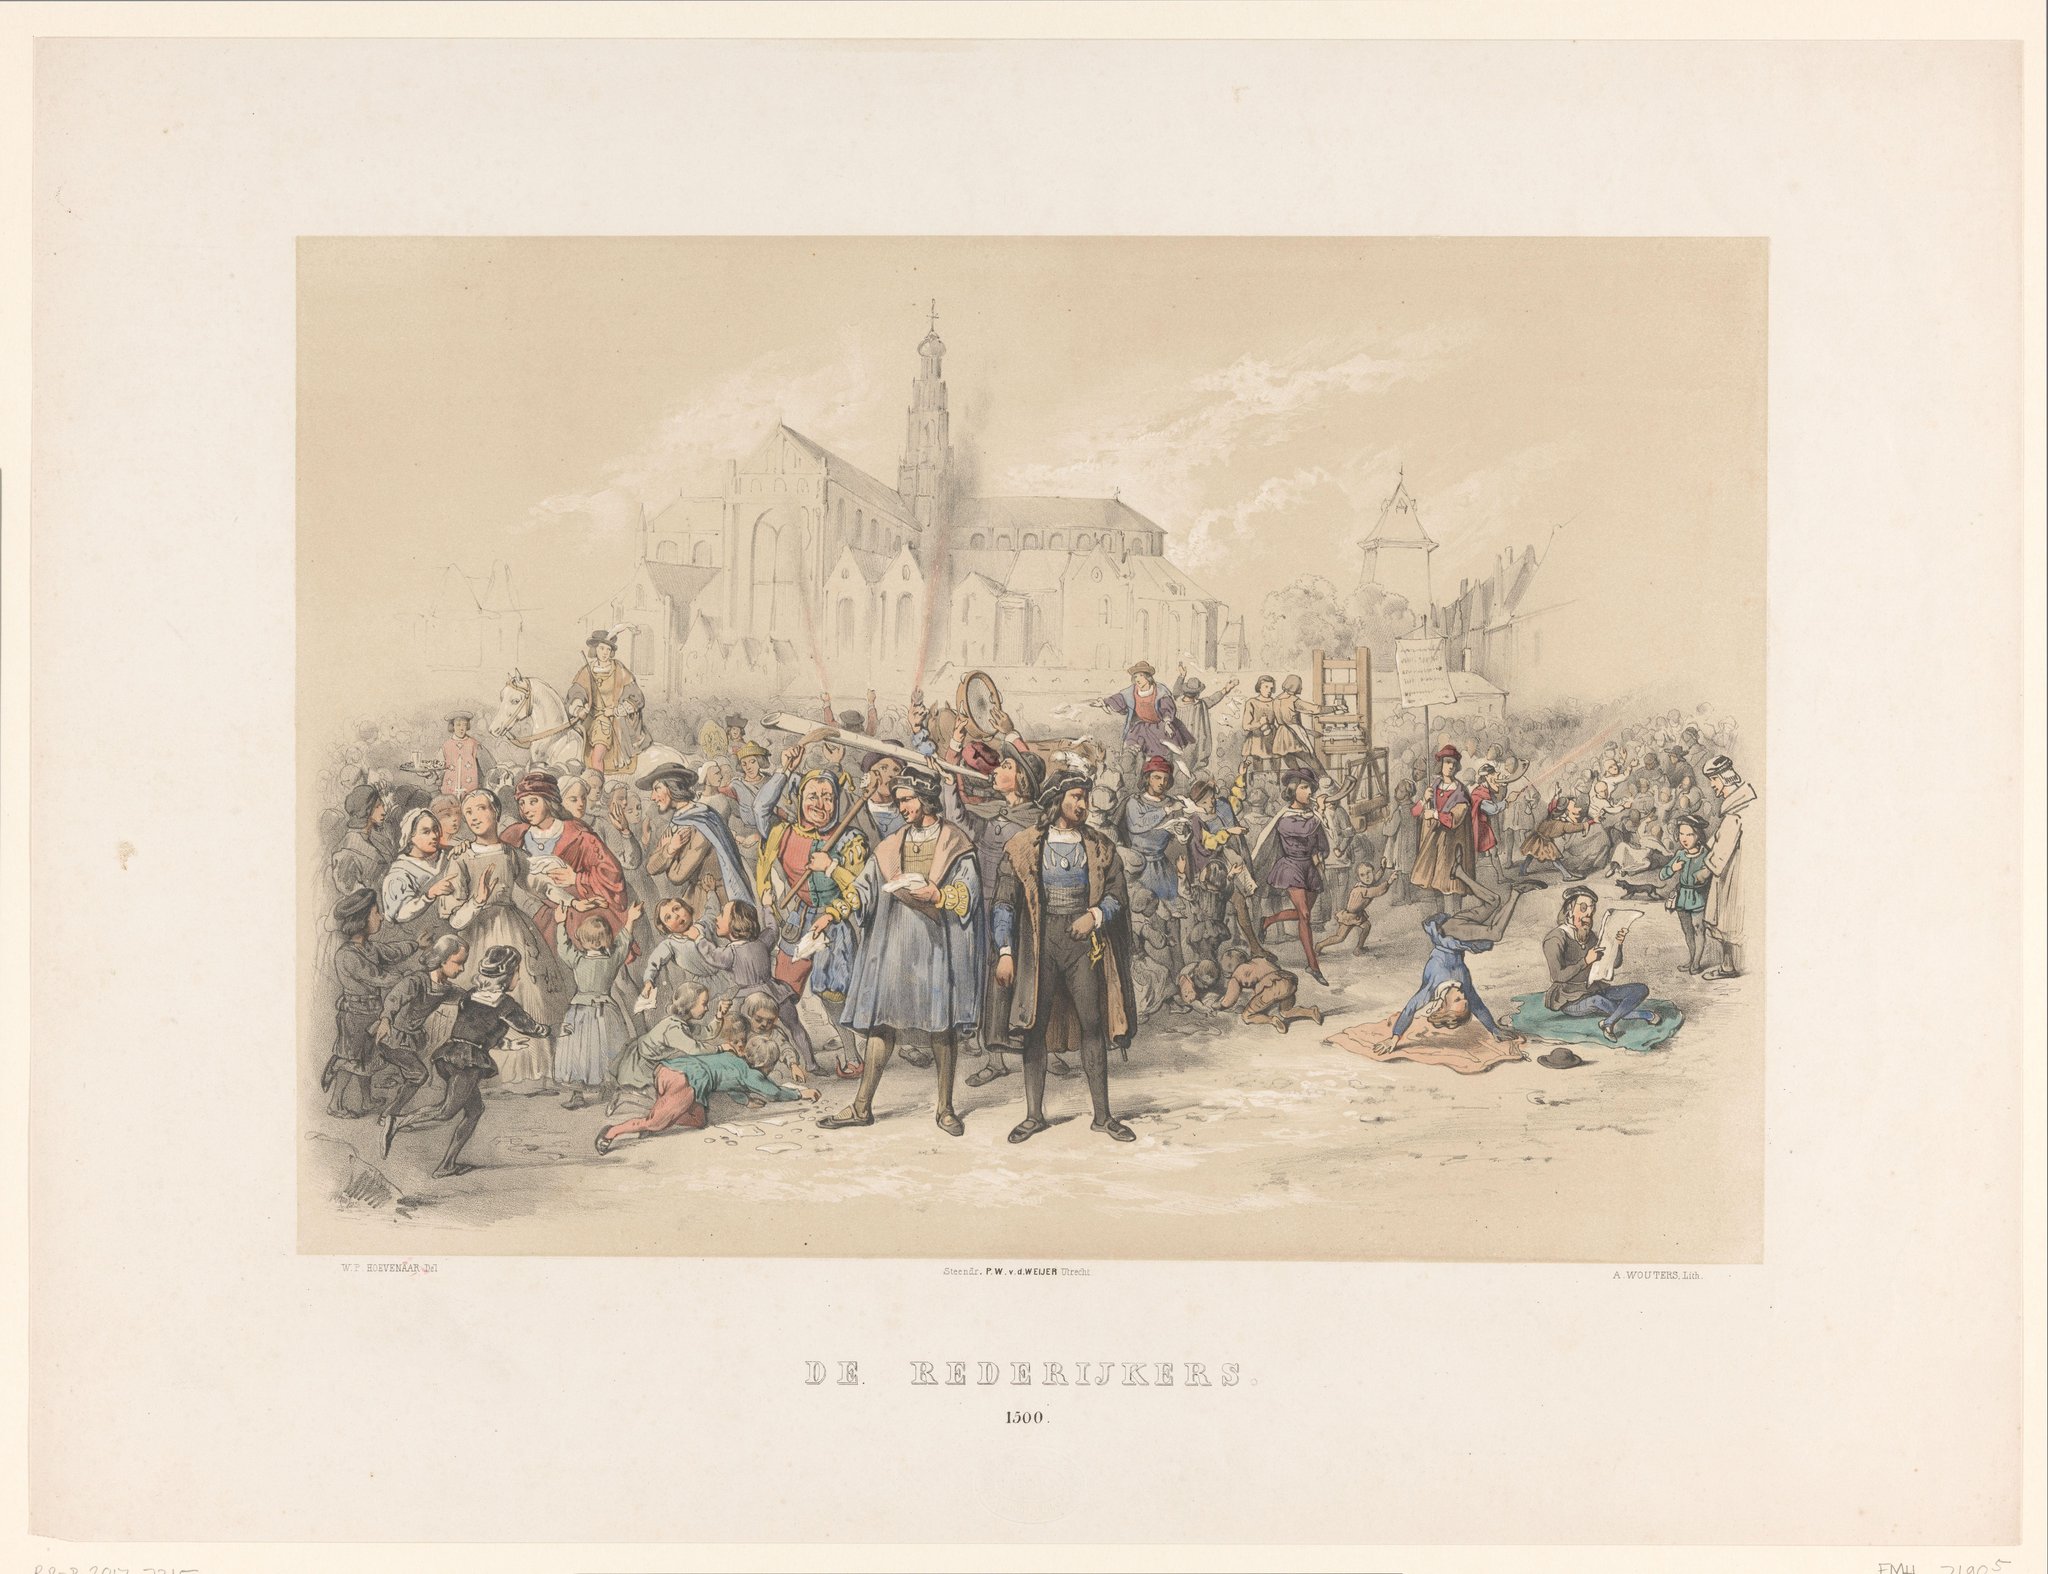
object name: print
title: De Vaderlandsche Geschiedenis. van de vroegste tijden tot op het einde der 17e eeuw, in acht taferelen, in costuum voorgesteld door H.H. Dtudenten der Utrechtsche Hoogeschool, den 25 Juny 1851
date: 1851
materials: paper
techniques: hand coloring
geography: utrecht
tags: students' pageant, chamber of rhetoric (dutch: 'rederijkerskamer'), haarlem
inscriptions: workshop stamp: ‘Dannenfelser & Doorman Uitgevers Utrecht’, collector's mark: Lugt 2228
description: Episode uit de tijd van de rederijkers, ca. 1500. Optocht van de leden van de Haarlemse rederijkerskamer De Wijngaertrancken (de Wijngaardranken) in Haarlem. Onderdeel van de serie van acht prenten van de maskerade van de studenten van de Utrechtse Hogeschool voorstellende episodes uit de vaderlandse geschiedenis, 25 juni 1851.